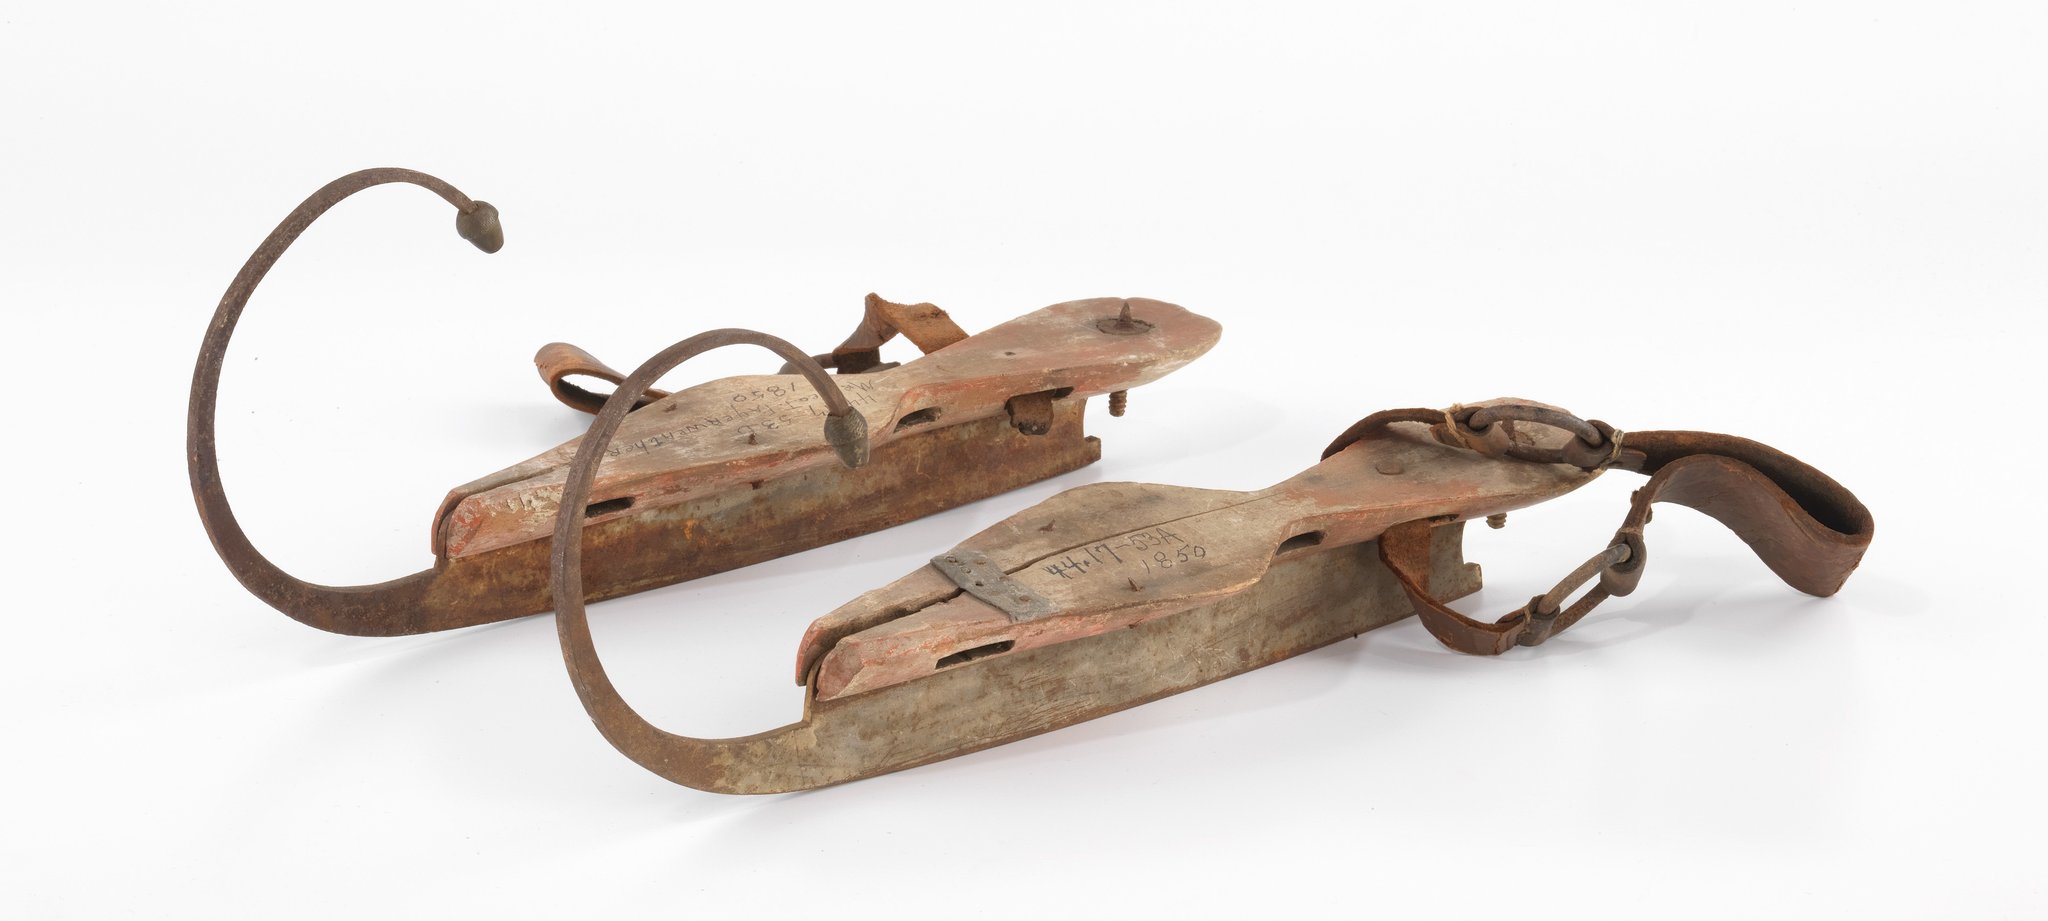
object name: ice skate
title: Ice skates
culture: american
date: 1840-1859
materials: leather, metal, wood